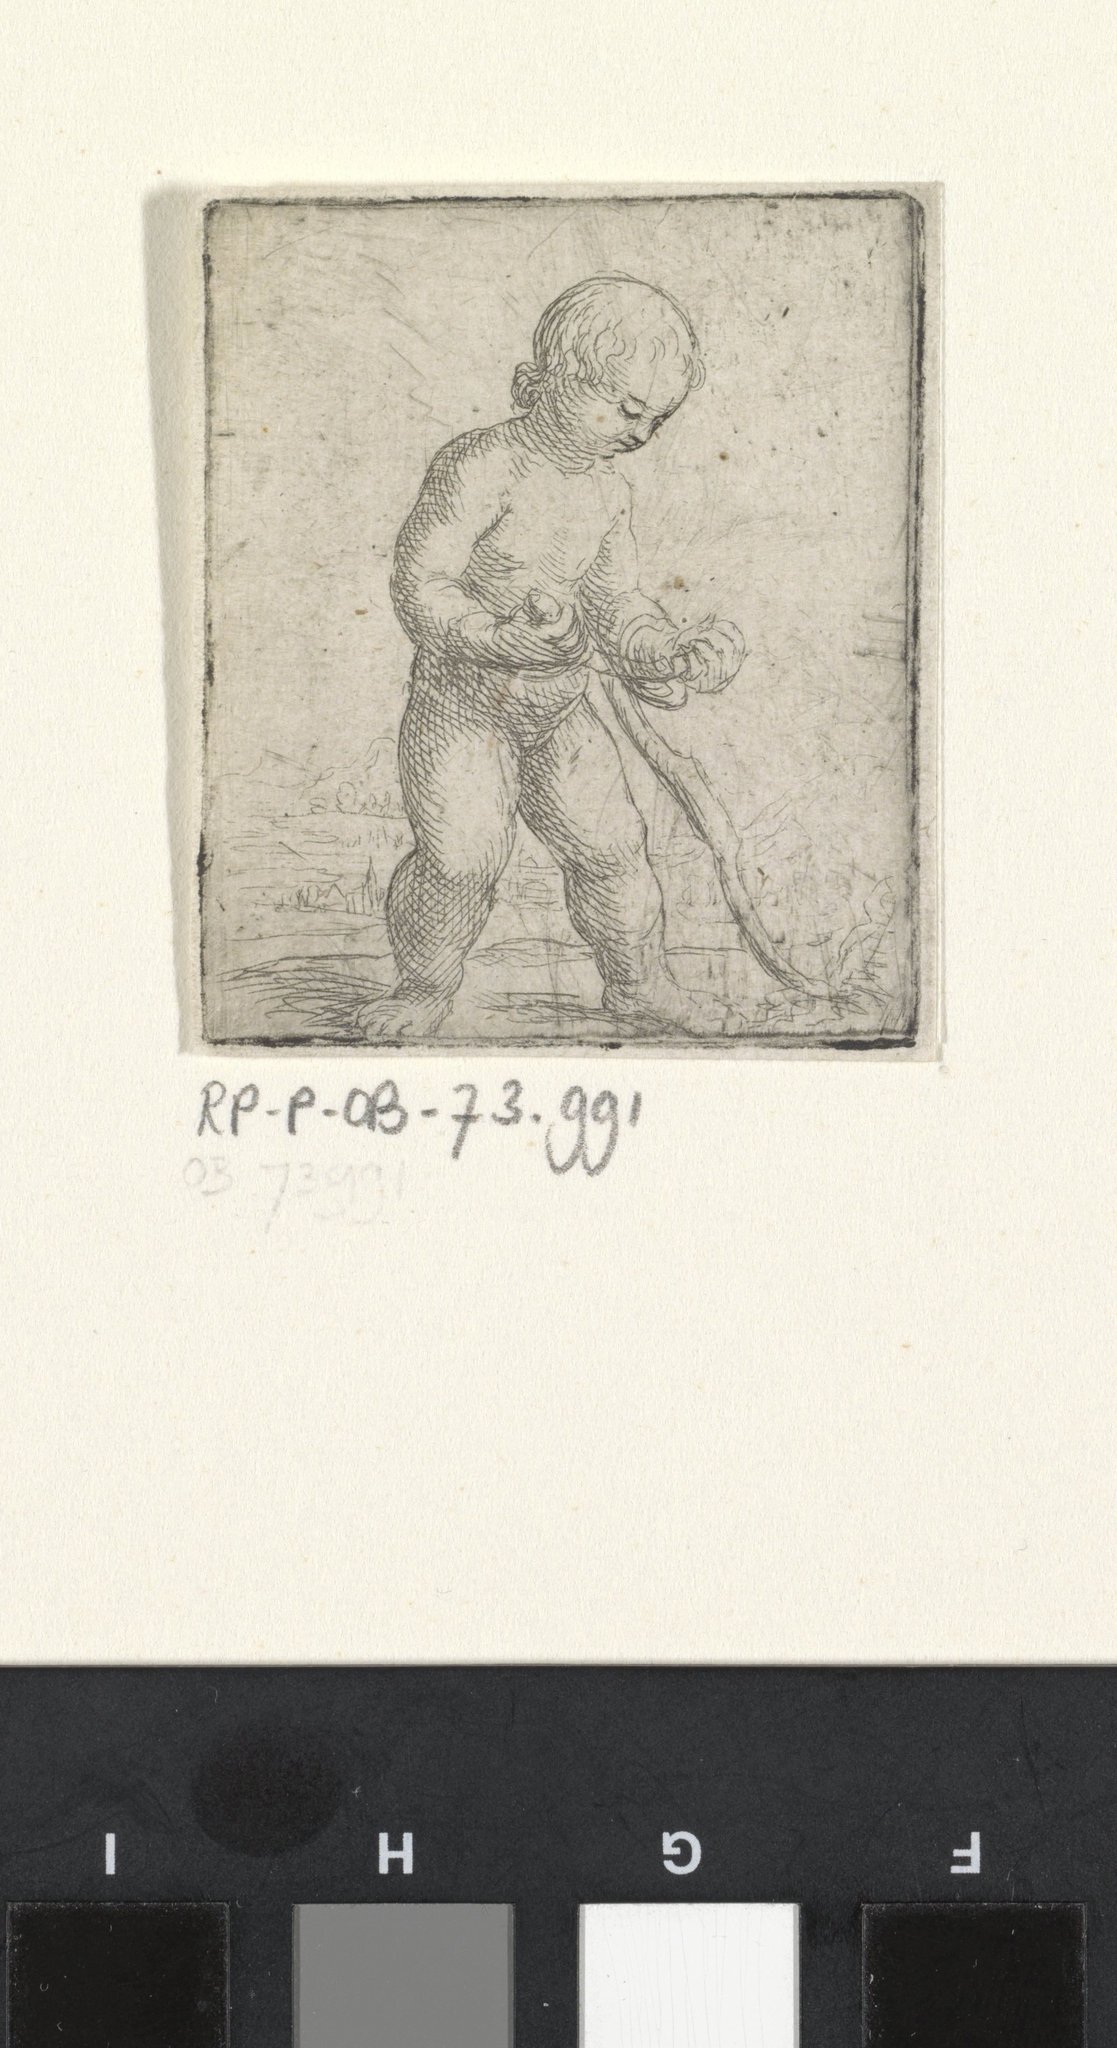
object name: print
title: Kind met een ploeg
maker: Anonymous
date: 1650-1750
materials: paper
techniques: etching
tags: agricultural implements: plough, cupids: 'amores', 'amoretti', 'putti'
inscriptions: collector's mark: Lugt 240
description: Een putto met een handploeg op een akker.